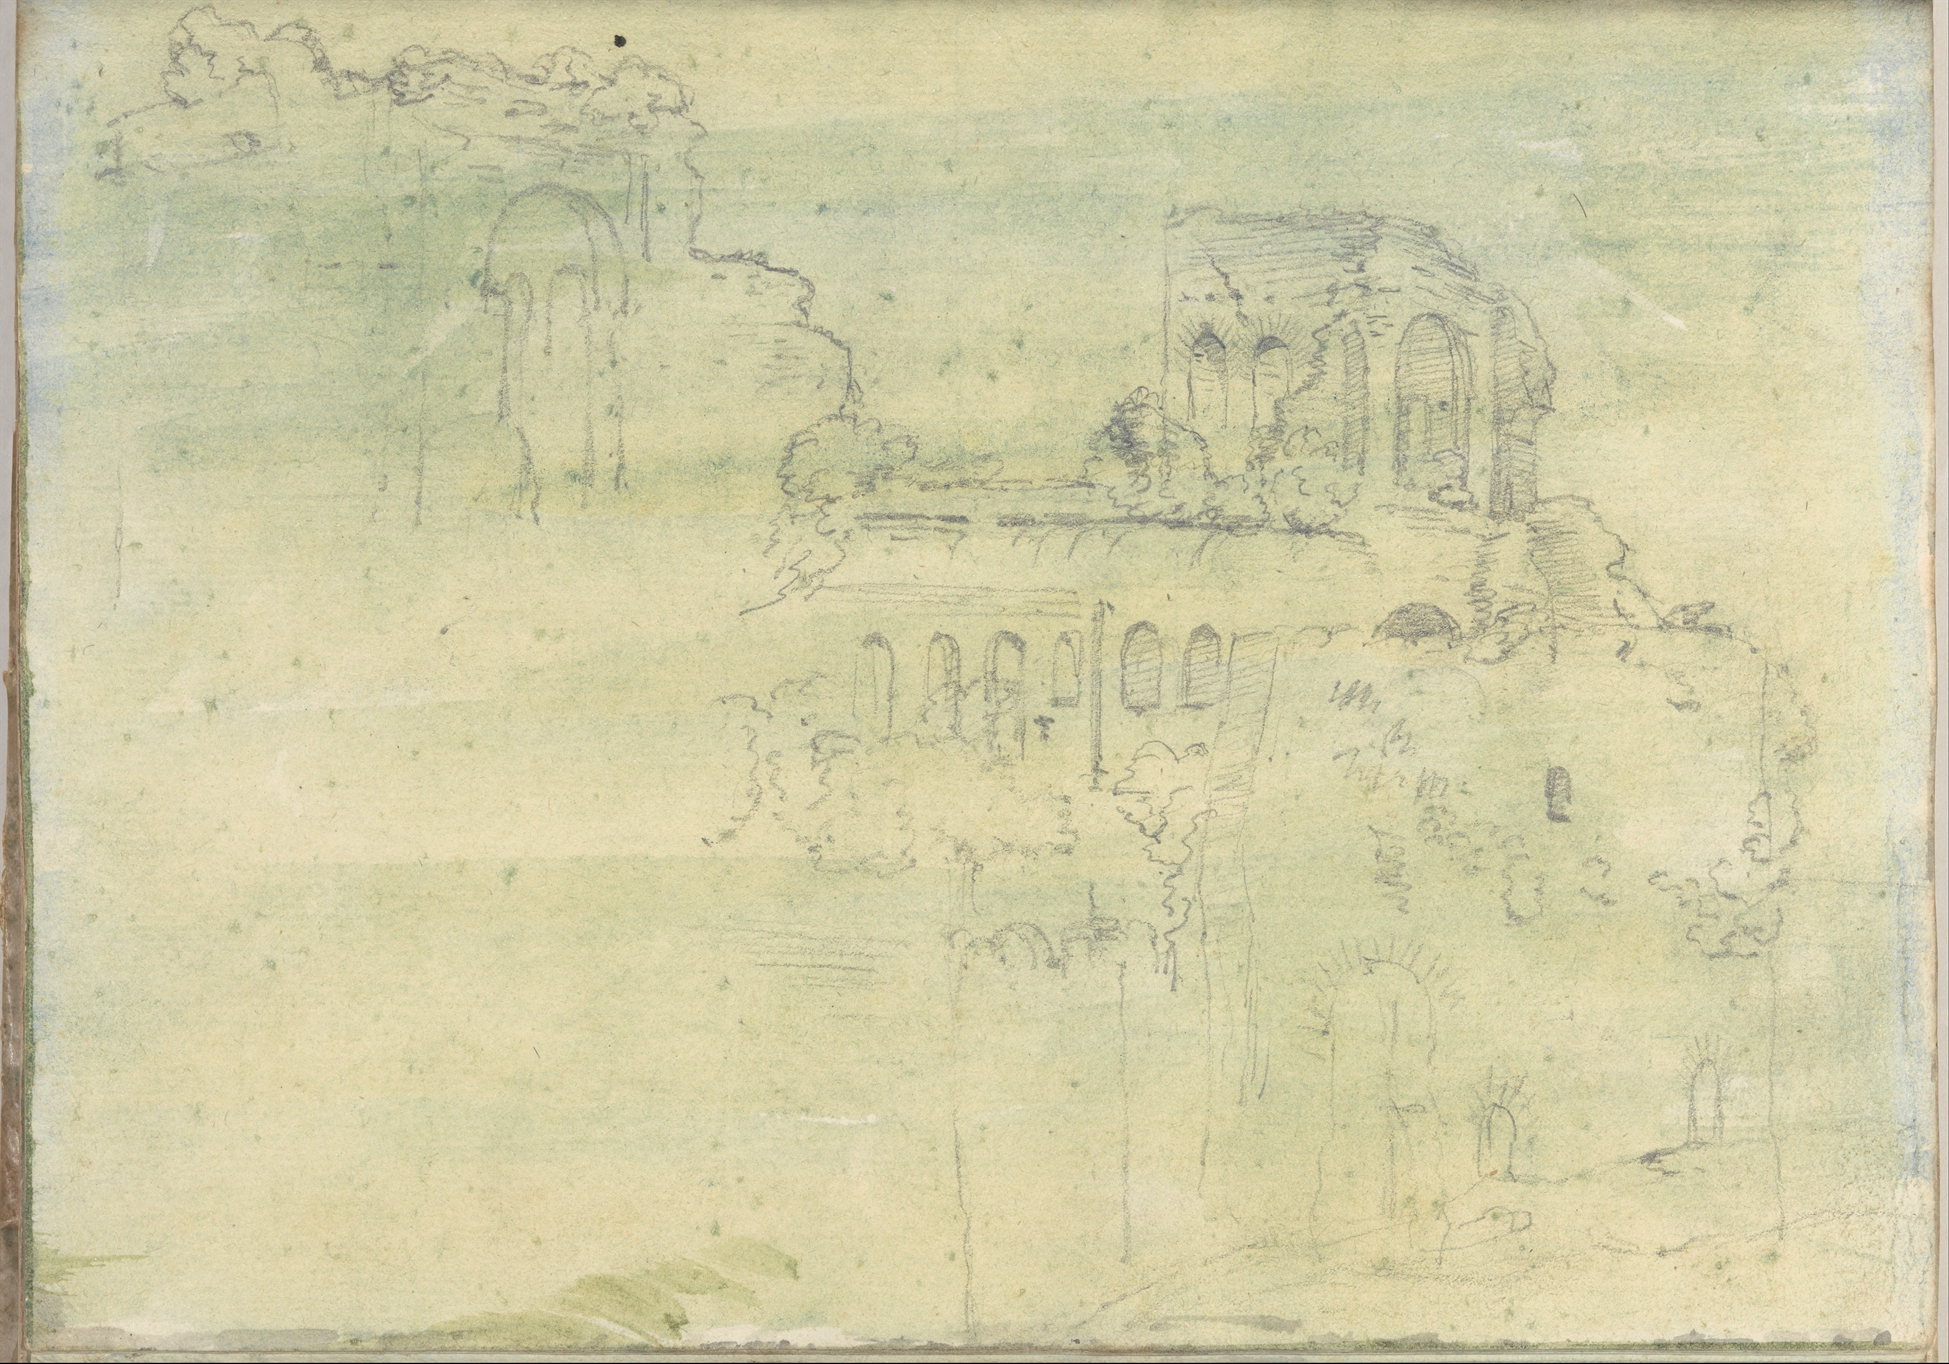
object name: drawing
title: Roman ruins (Smaller Italian sketchbook, leaf 12 recto)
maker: joseph wright (wright of derby)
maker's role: artist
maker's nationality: british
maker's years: 1734-1797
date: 1774-1775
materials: graphite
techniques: brush, wash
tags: ruins